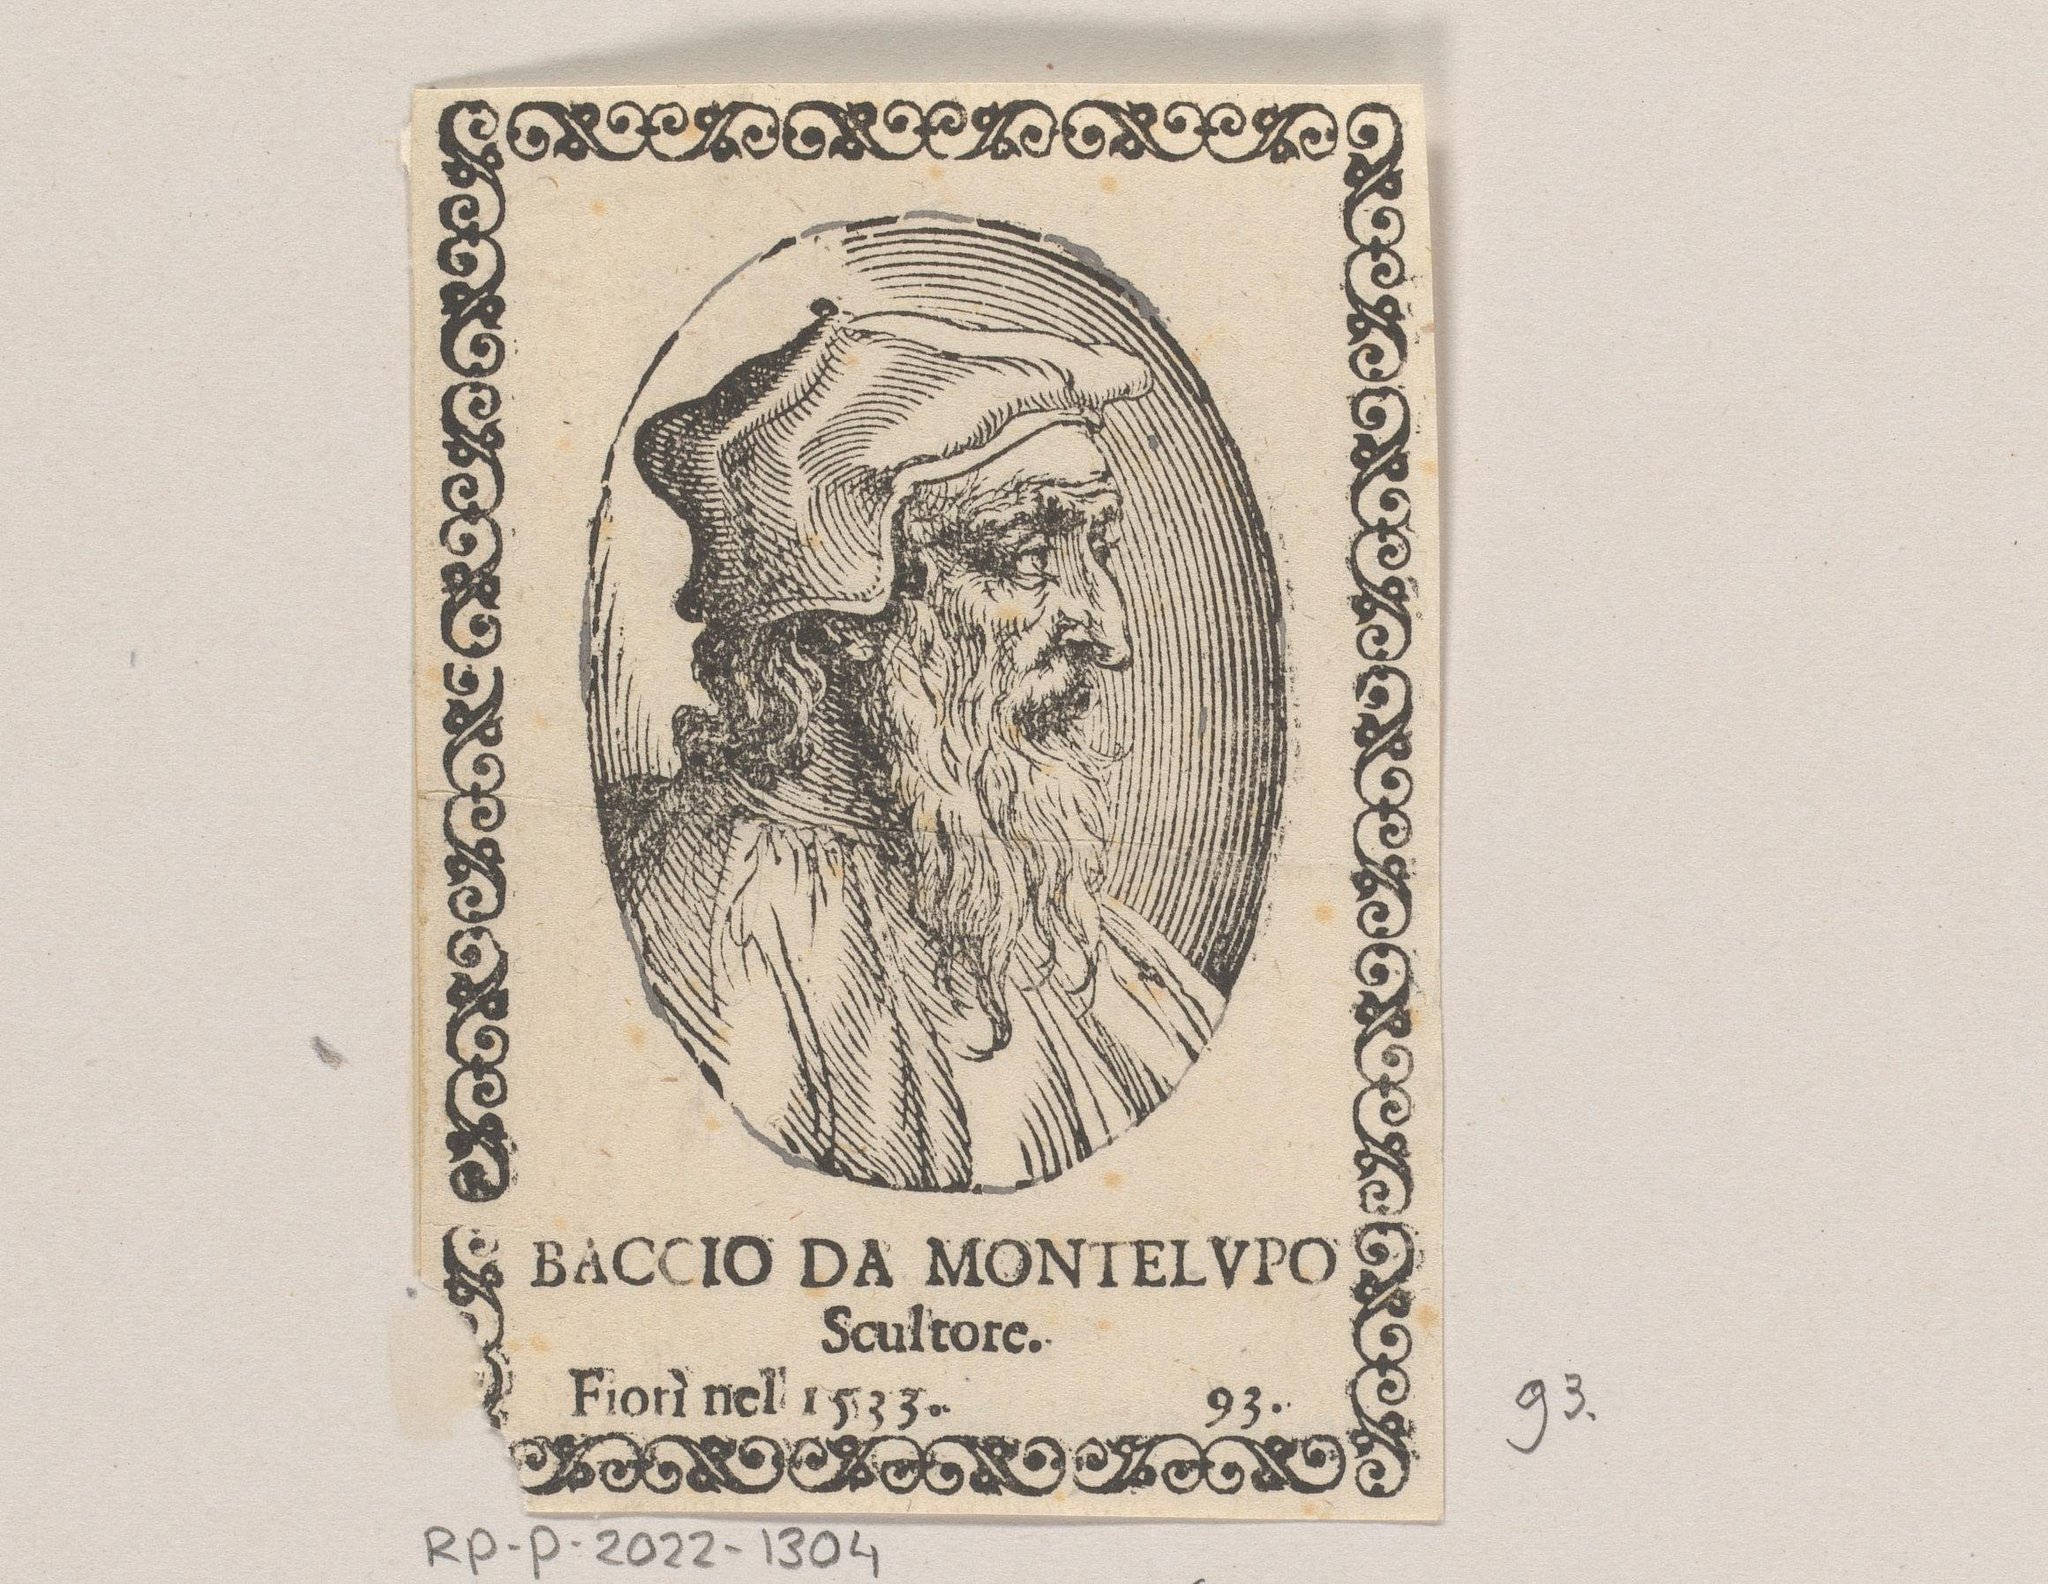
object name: print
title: Portret van Baccio da Montelupo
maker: cristoforo coriolano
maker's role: print maker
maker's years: 1540-1610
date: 1568-1650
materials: paper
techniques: letterpress printing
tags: baccio da montelupo, portrait, self-portrait of sculptor, historical persons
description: Prent komt vermoedelijk uit een editie van Vasari's 'Vite'. Vergelijkbare prenten zijn bijvoorbeeld gebruikt in de edities uit 1568 en 1647.